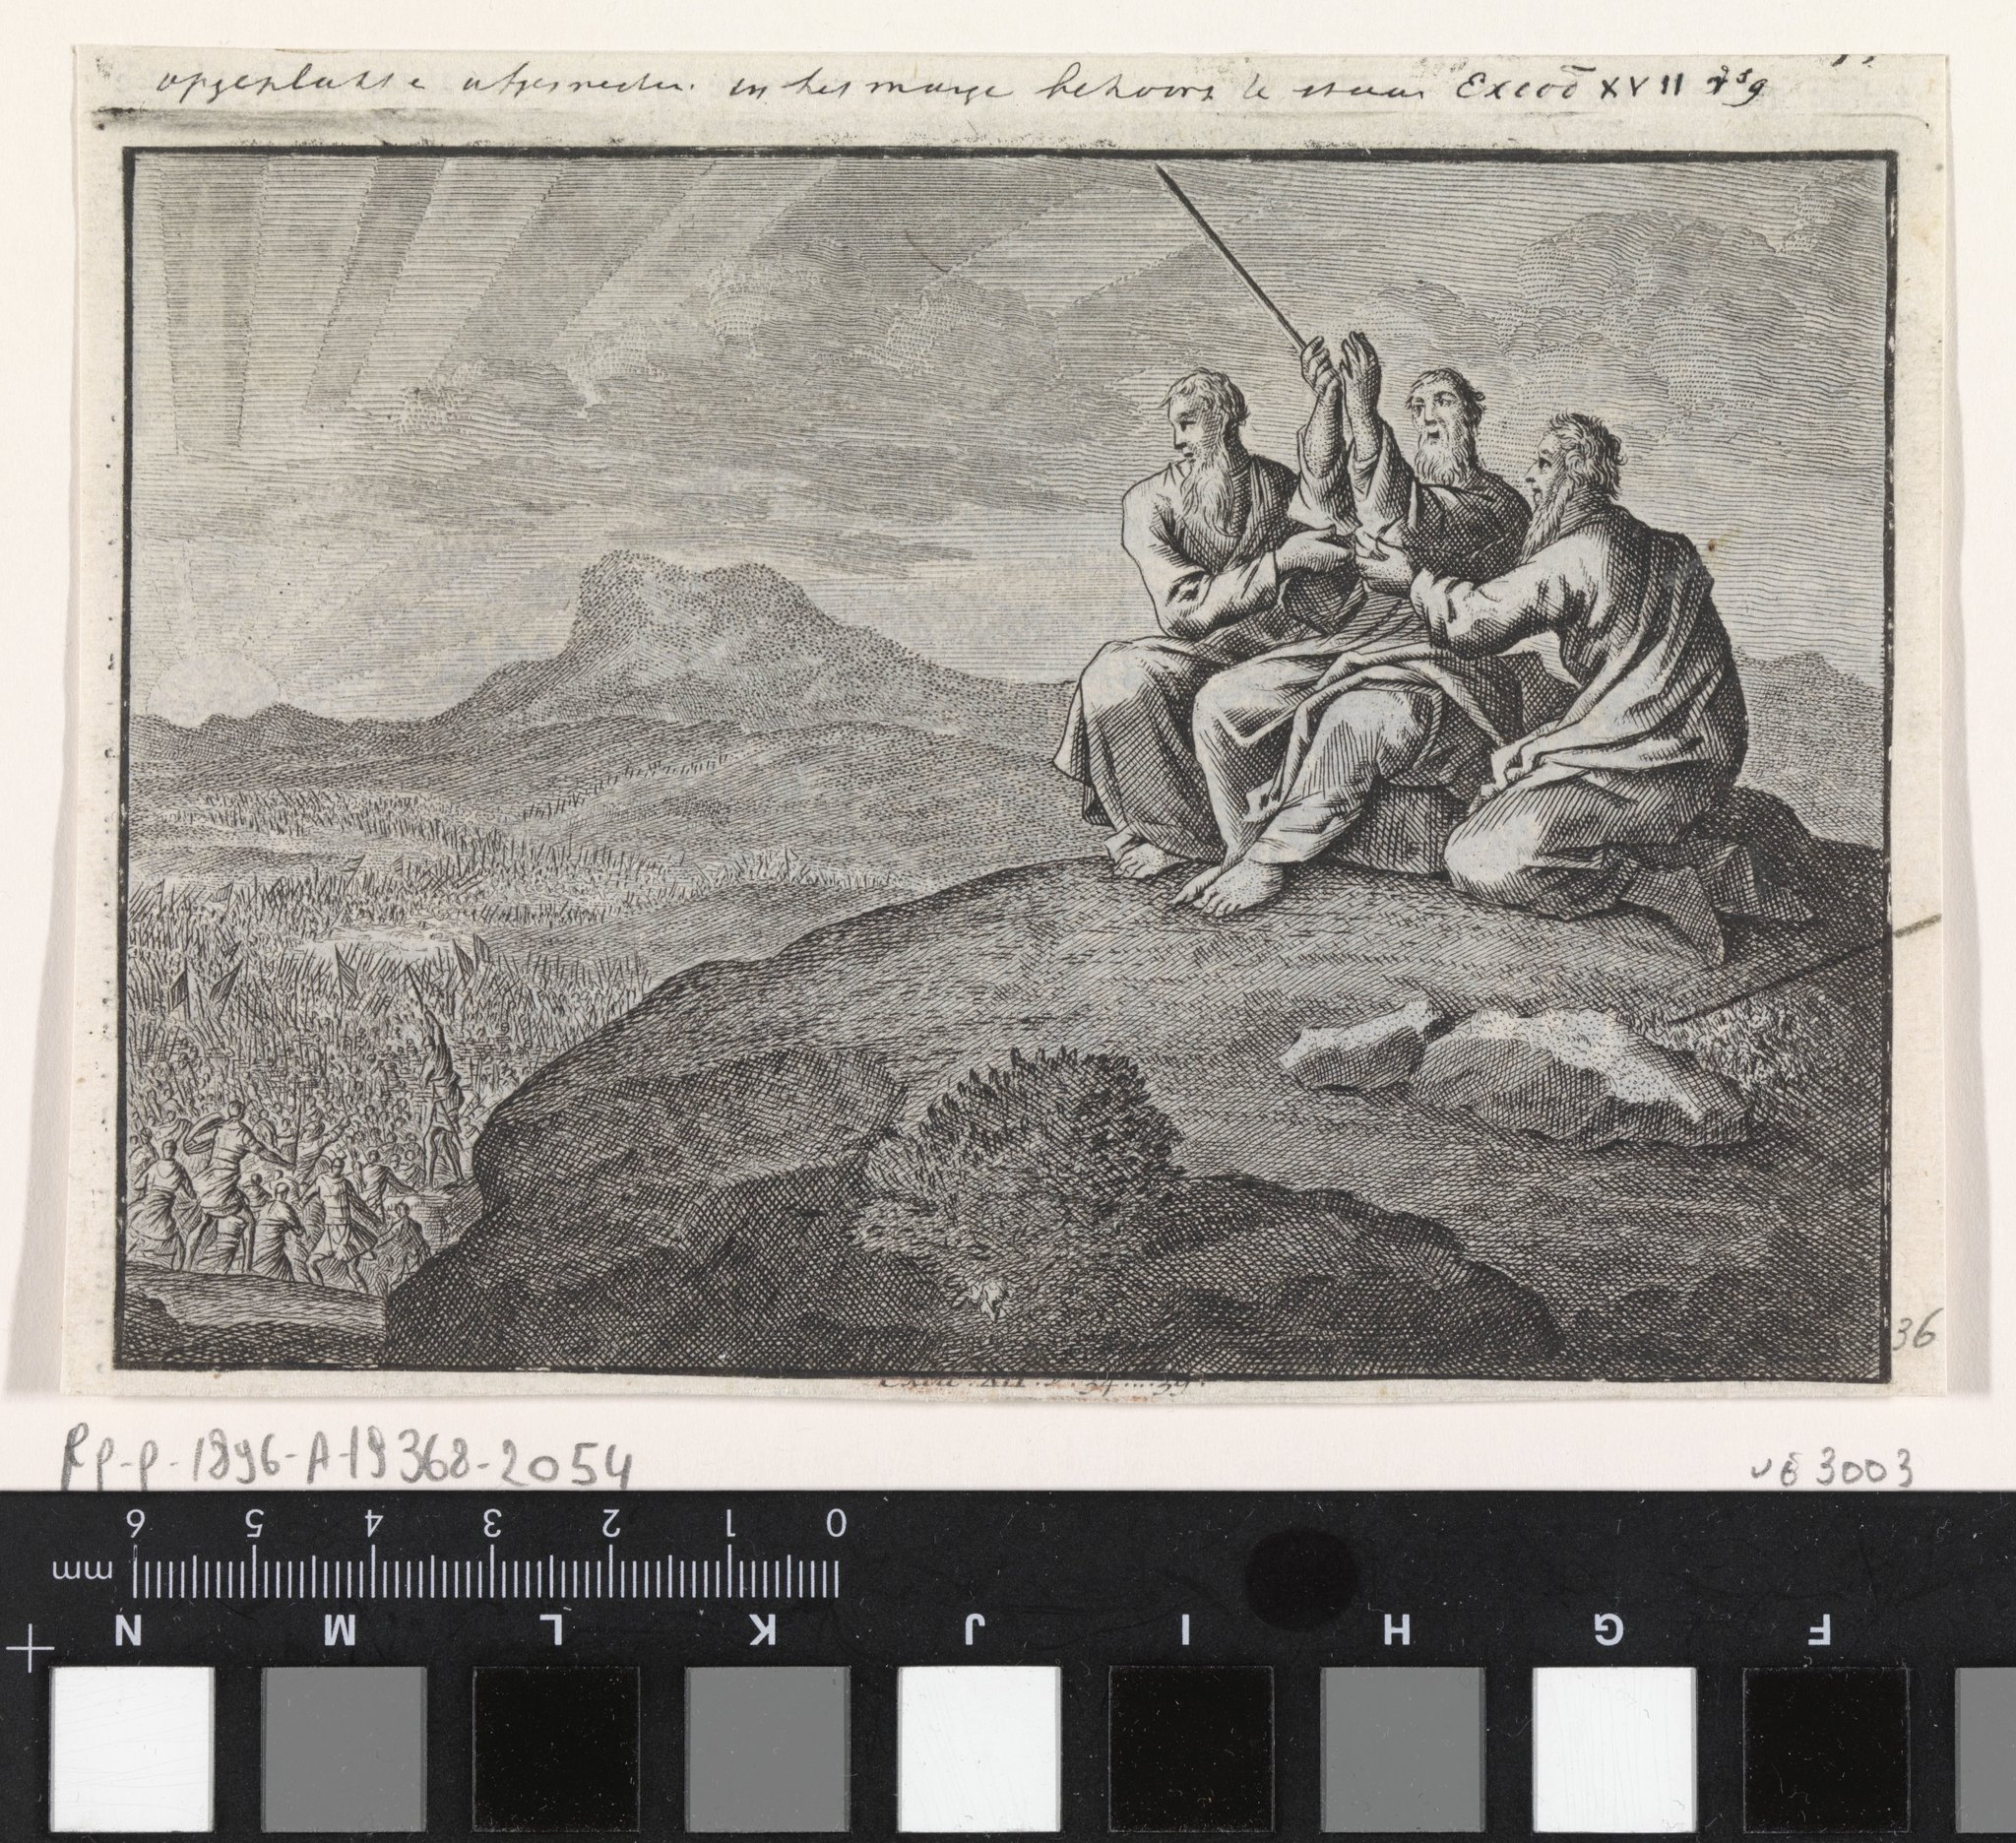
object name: print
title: Aäron en Chur stutten Mozes' handen tijdens de strijd van het volk Israël tegen de Amalekieten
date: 1703-1762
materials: paper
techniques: etching, letterpress printing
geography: haarlem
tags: moses goes to the top of a hill with aaron and hur and raises his arms to make the israelites victorious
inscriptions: collector's mark: Lugt 2228, inscription: ‘opgeplakt en afgesneden en het marge behoort te staan Exod XVII v. 9’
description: De prent komt een eerste keer voor als boekillustratie voor David Martin. Historie des Ouden en Nieuwen Testaments. Amsterdam, Pieter Mortier, 1703. Deel I. De boekillustraties voor de Mortierbijbel hebben verschillende staten en kopieën, waarbij de chronologische volgorde moeilijk te achterhalen valt. Als boekillustraties werden ze bovendien herhaaldelijk opnieuw gebruikt voor andere boekwerken.